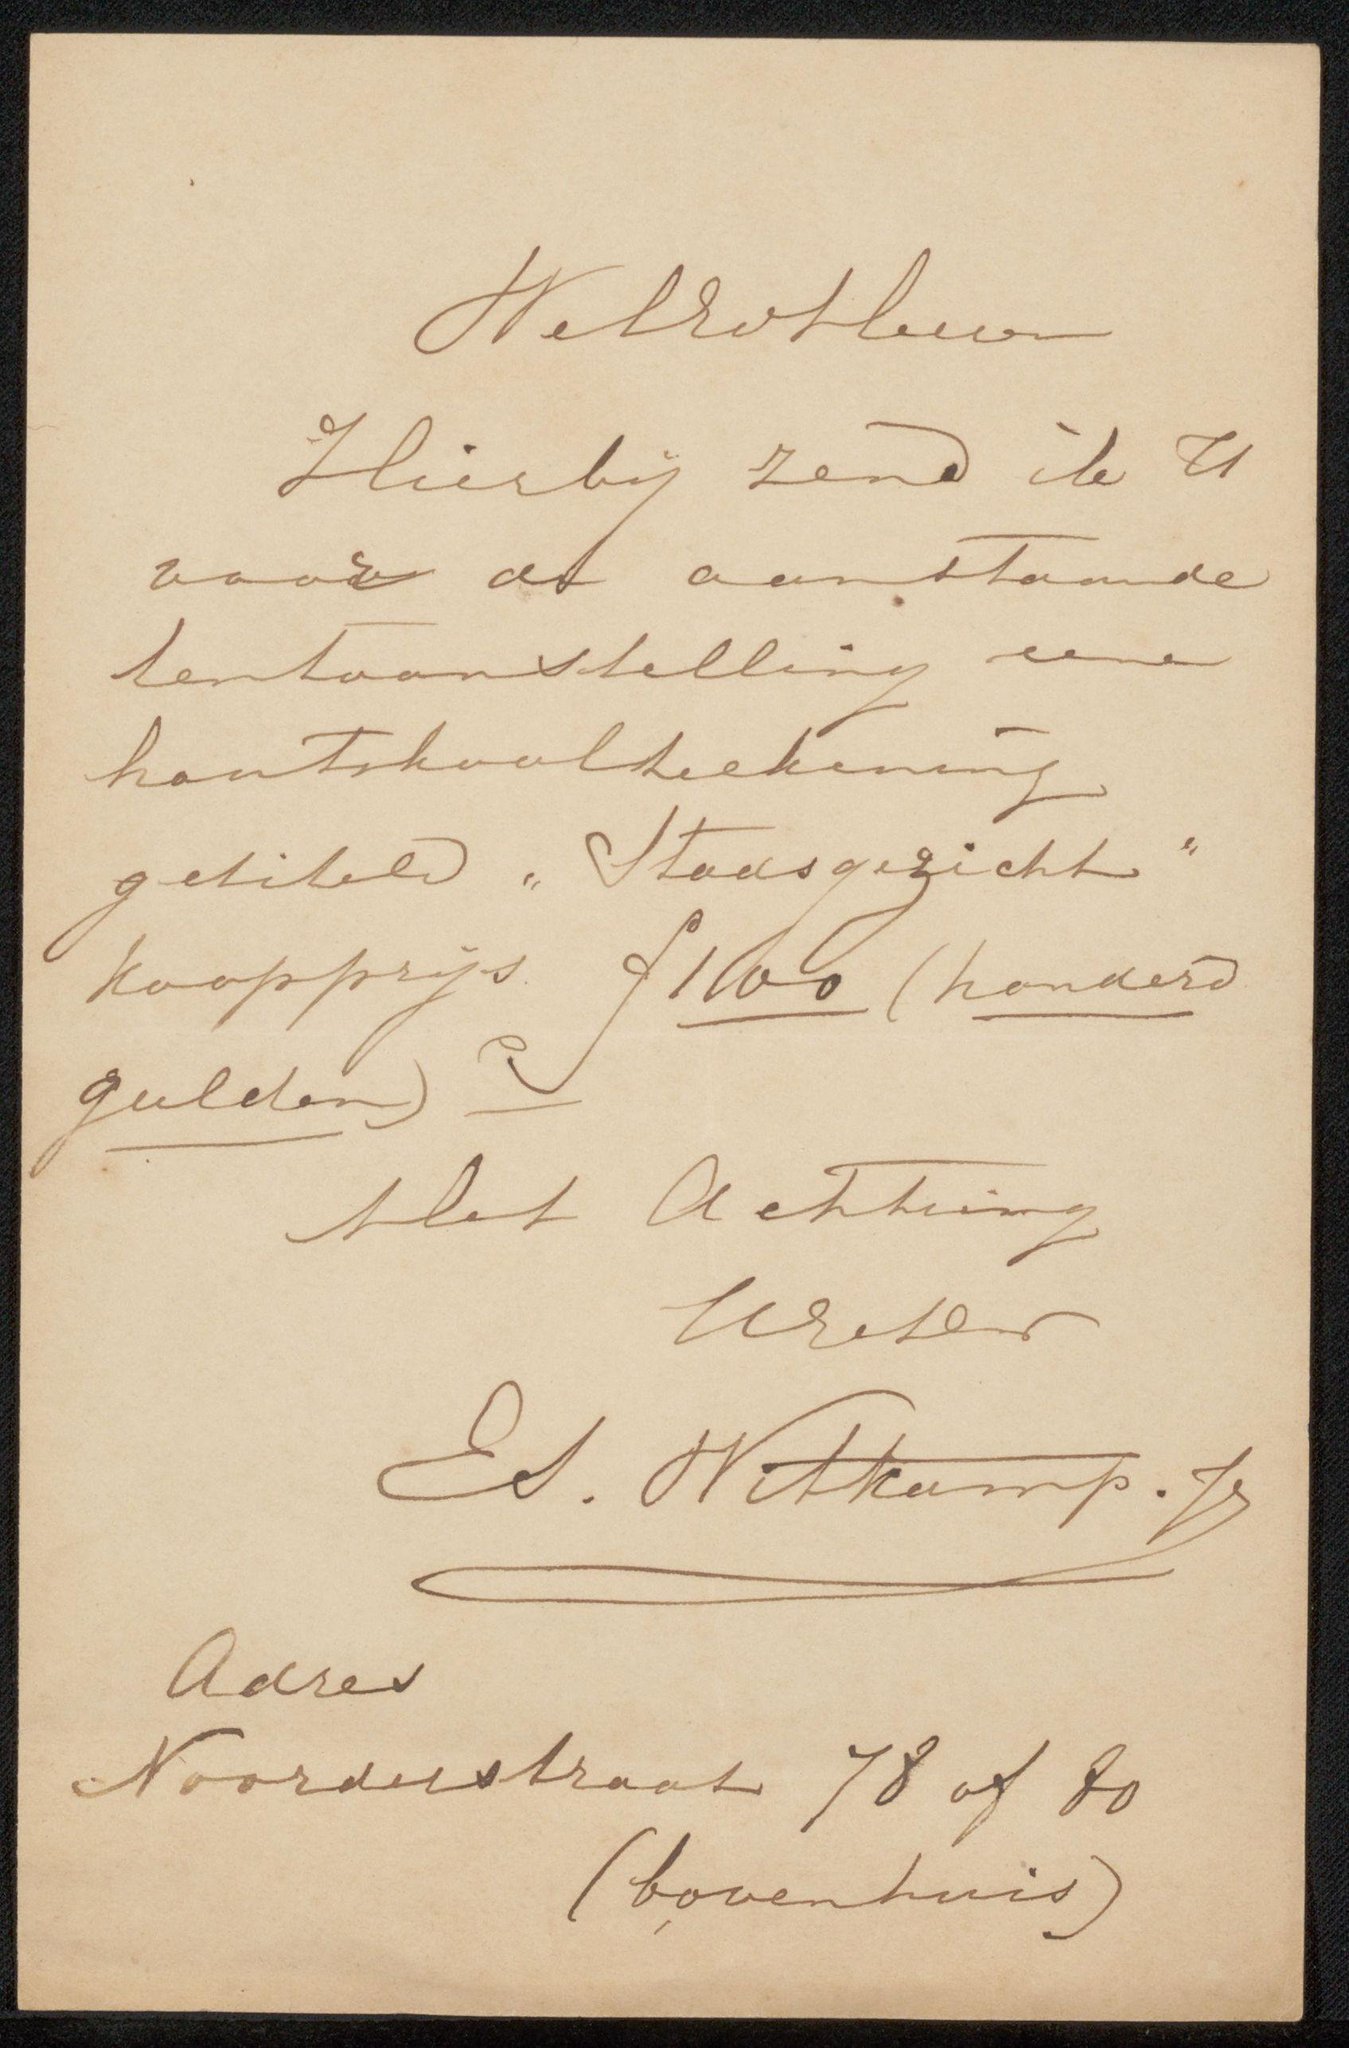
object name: letter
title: Brief aan Philip Zilcken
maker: ernst witkamp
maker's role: draughtsman, print maker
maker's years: 1854-1897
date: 1867-1897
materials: ink, paper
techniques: pen, writing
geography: amsterdam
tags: painter, philip zilcken, drawing, exhibition ~ art, money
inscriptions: collector's mark: ‘RPK’